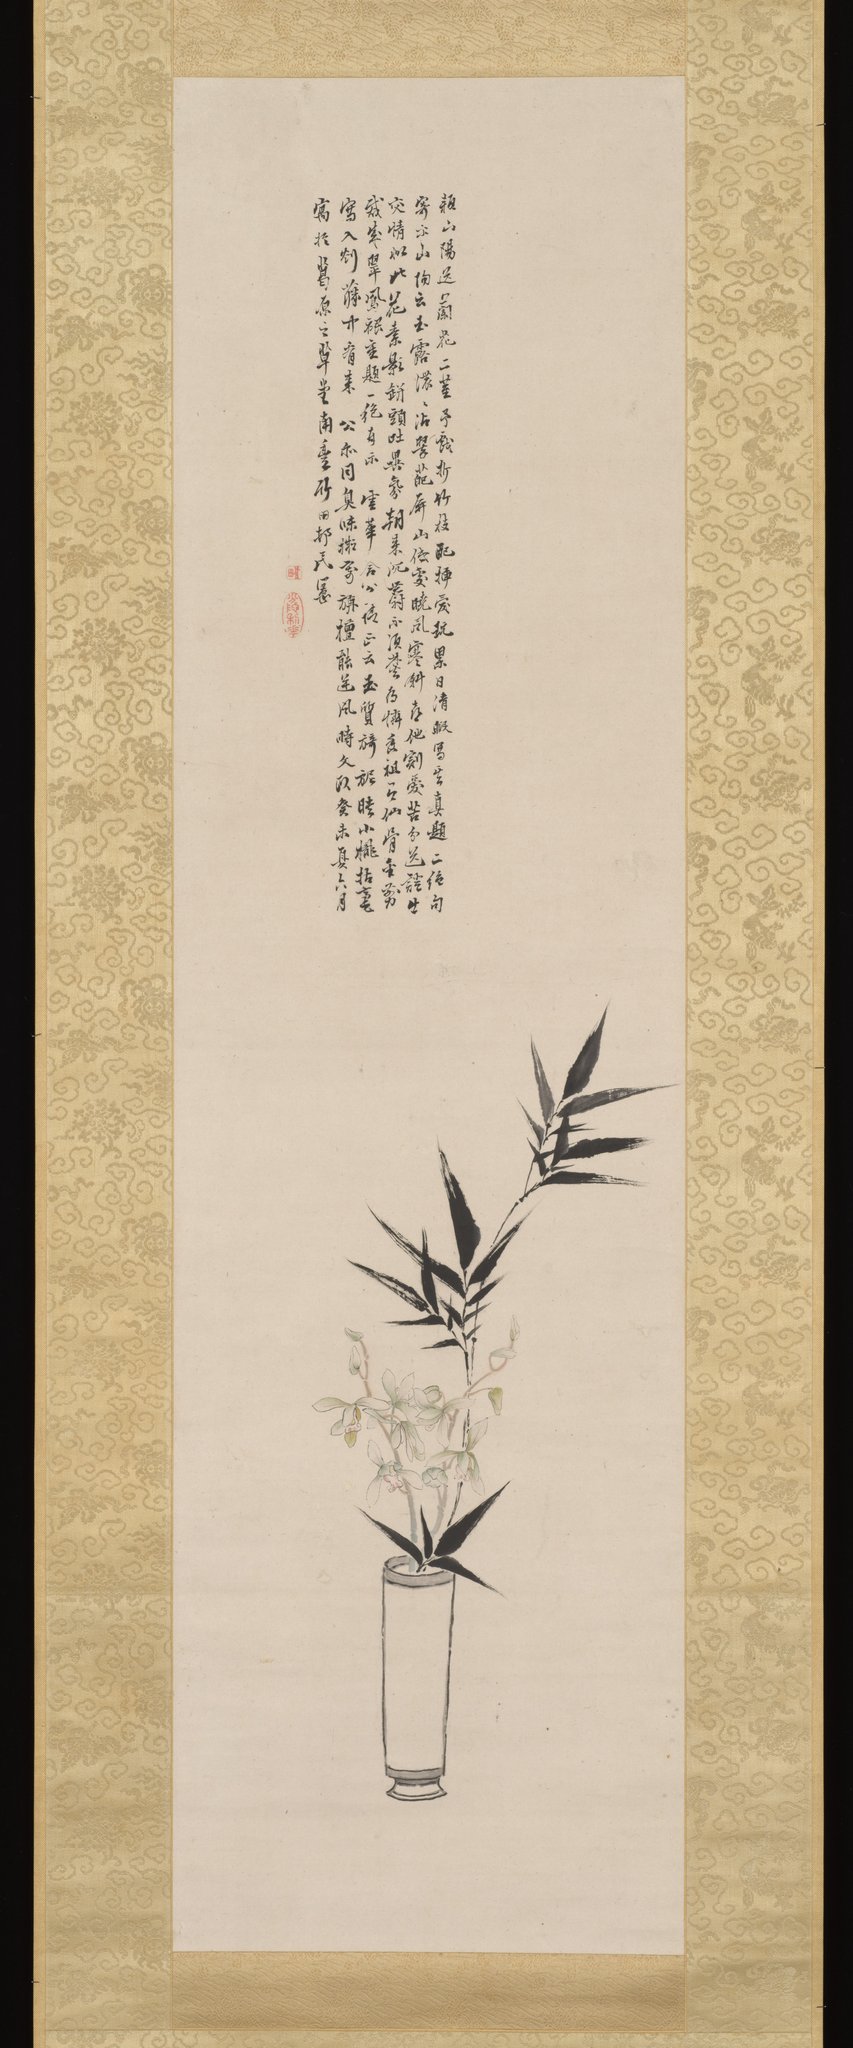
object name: hanging scroll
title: Orchid and Bamboo in a Vase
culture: japanese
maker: tanomura chikuden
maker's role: artist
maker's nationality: japanese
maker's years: 1777-1835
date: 1823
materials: ink, paper